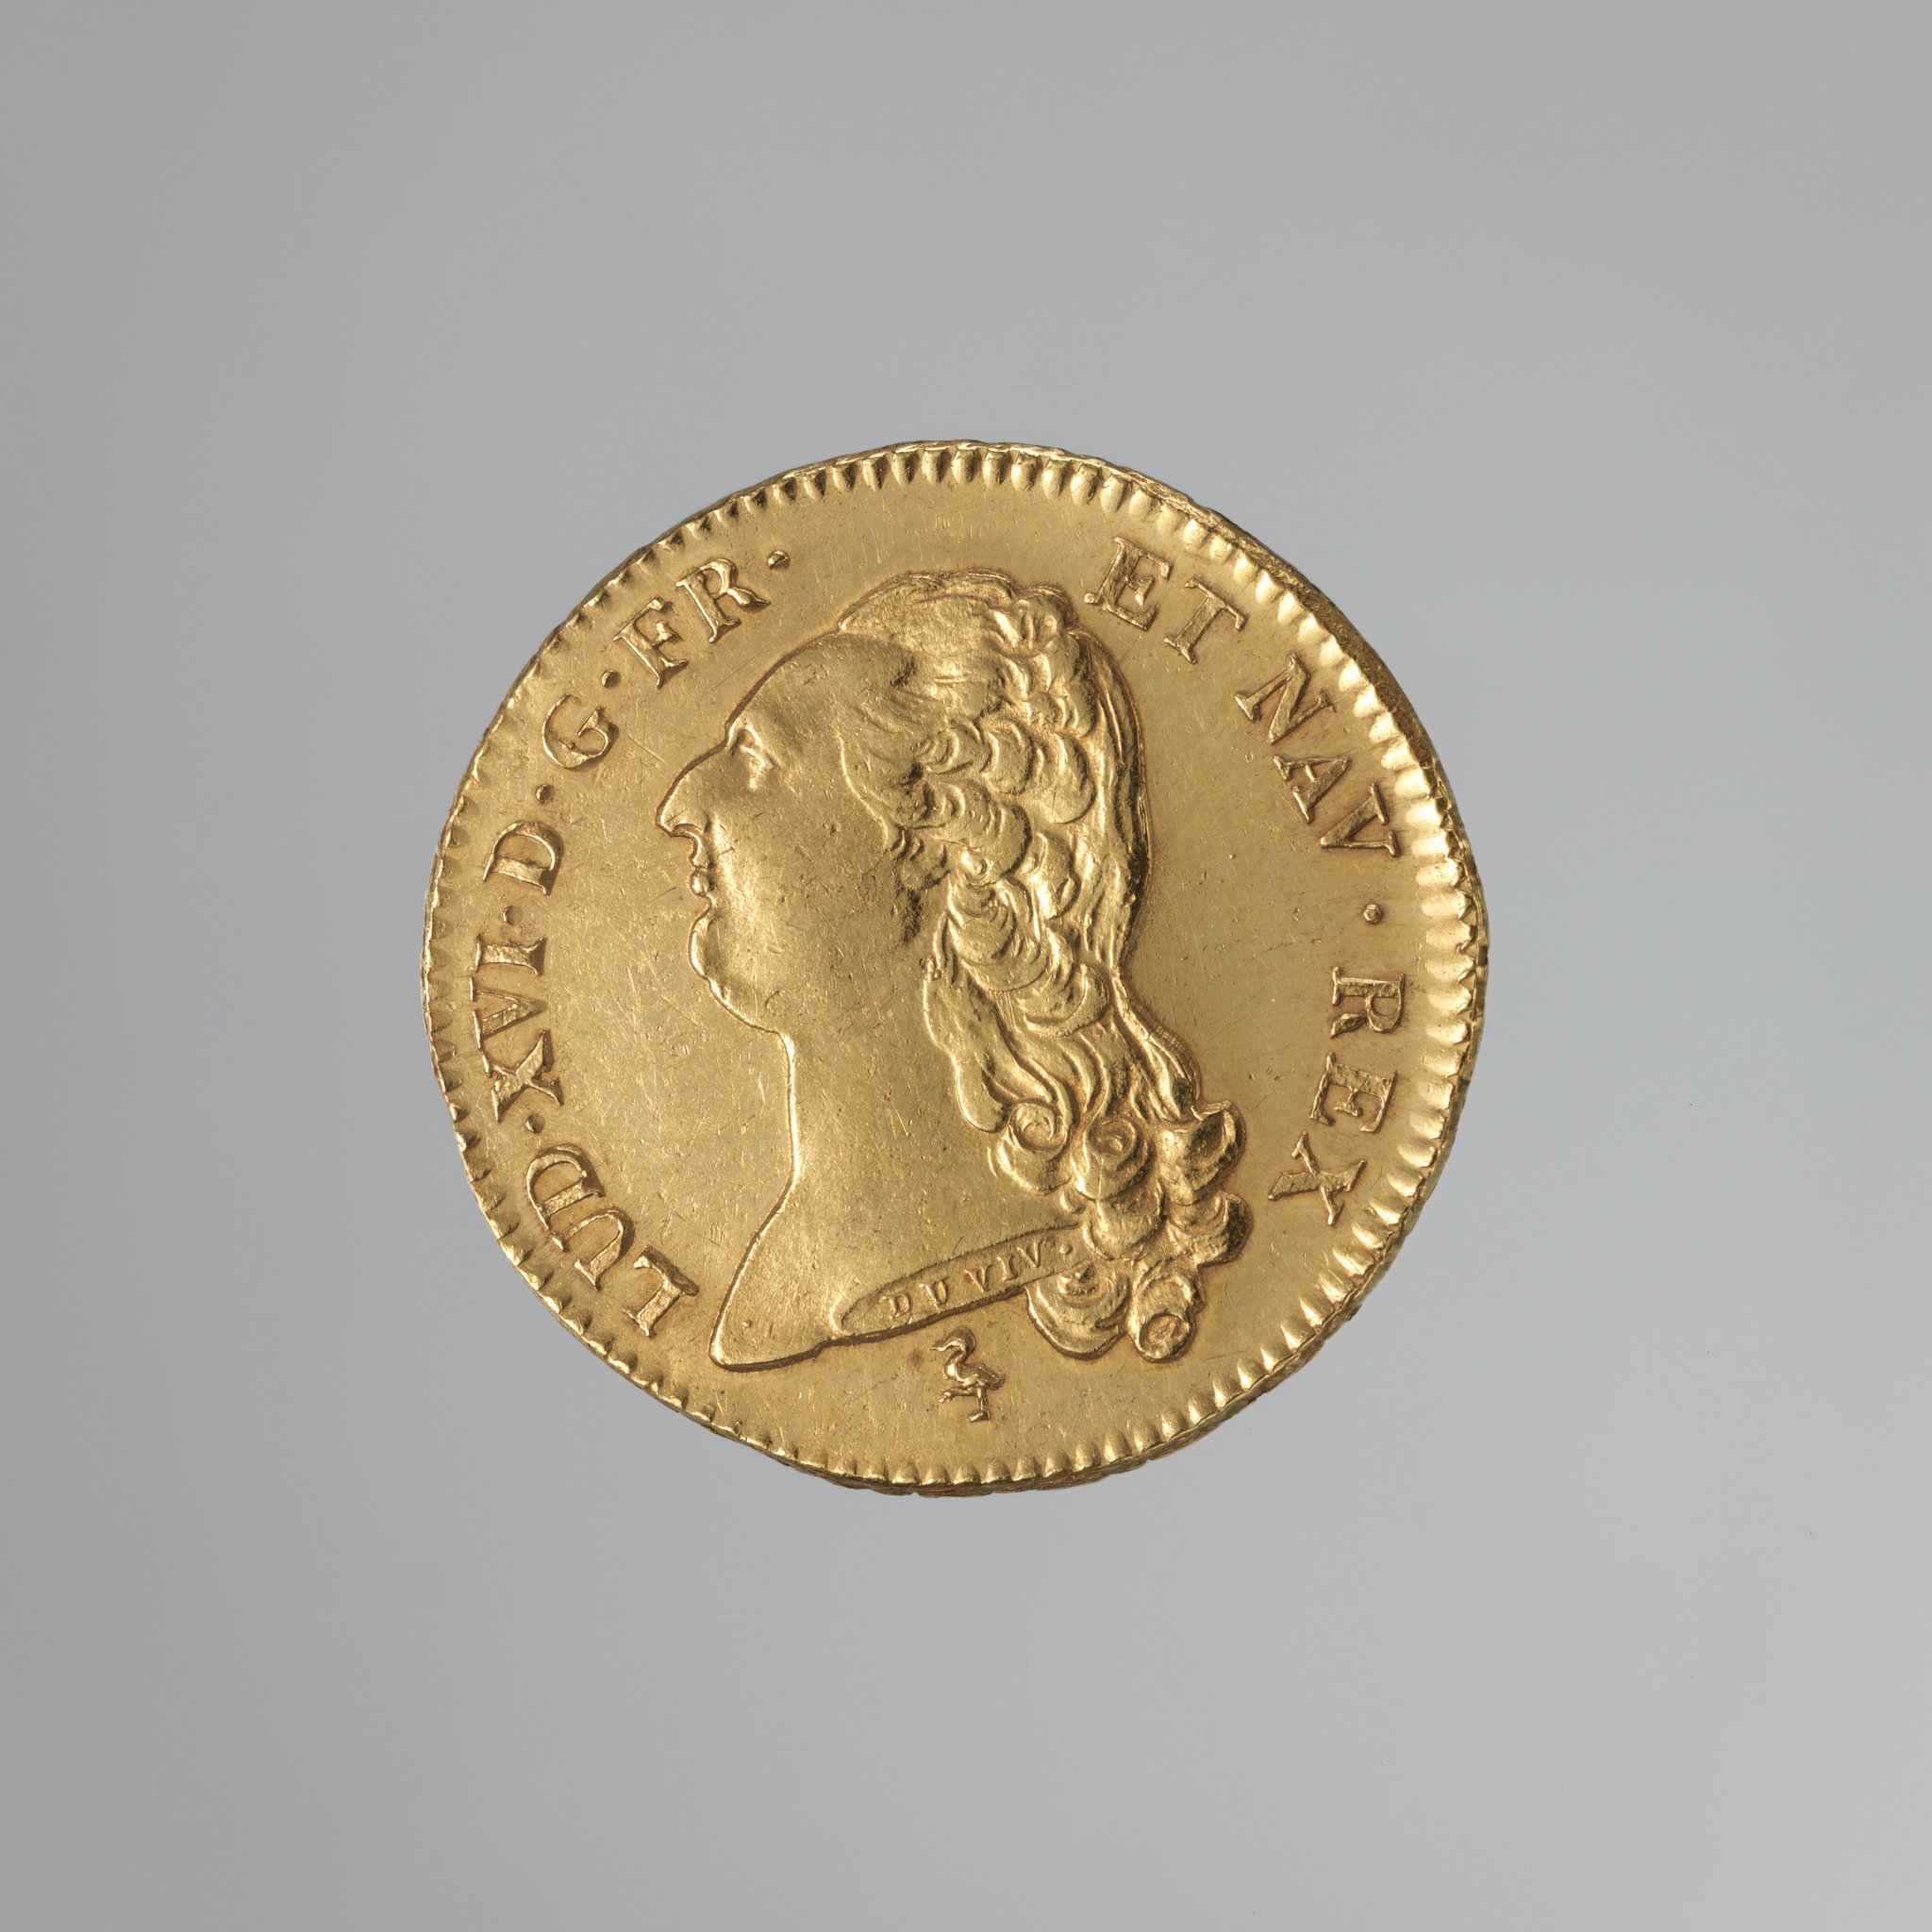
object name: coin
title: Double Louis d’or of Louis XVI of France (b. 1754-93; r. 1774–1792)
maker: pierre-simon-benjamin duvivier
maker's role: maker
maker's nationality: french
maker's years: 1730-1819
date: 1786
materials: gold